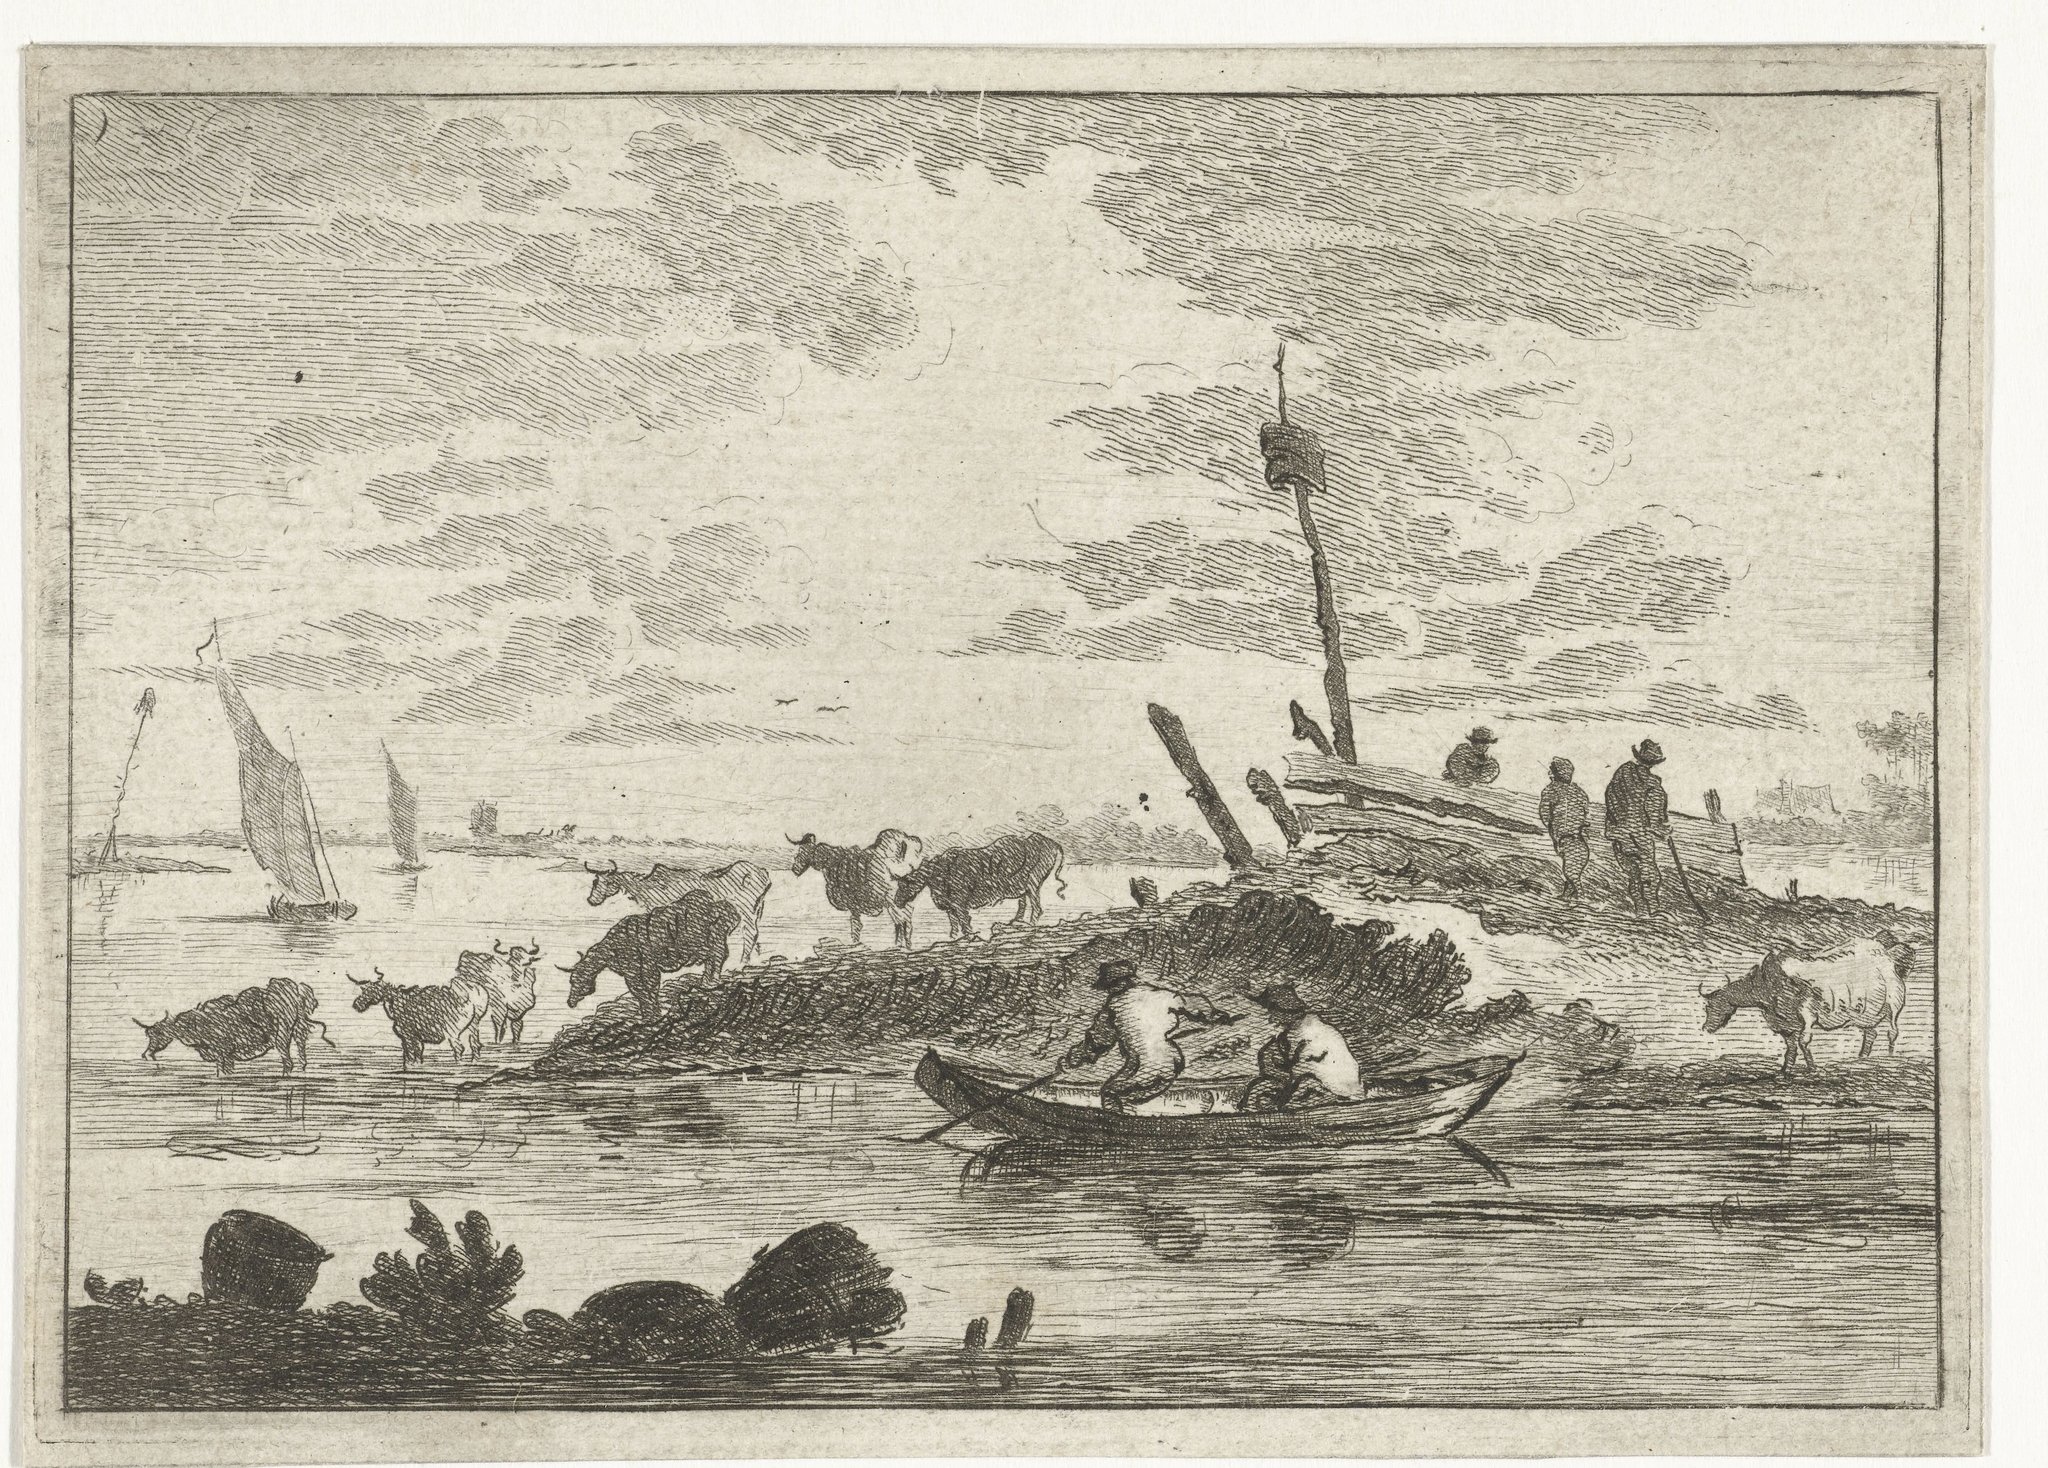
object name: print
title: Koeien aan het water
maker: anthonij van der haer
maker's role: print maker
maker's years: 1730-1785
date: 1745-1785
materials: paper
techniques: etching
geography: northern netherlands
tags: cattle, landscapes with waters, waterscapes, seascapes (in the temperate zone) (+ landscape with figures, staffage)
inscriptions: collector's mark: Lugt 2228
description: Een kudde koeien aan de waterkant, enkele koeien met hun poten in de rivier. Op de oever een hek waartegen drie mannen leunen, een schuitje met twee mannen op het water op de voorgrond.